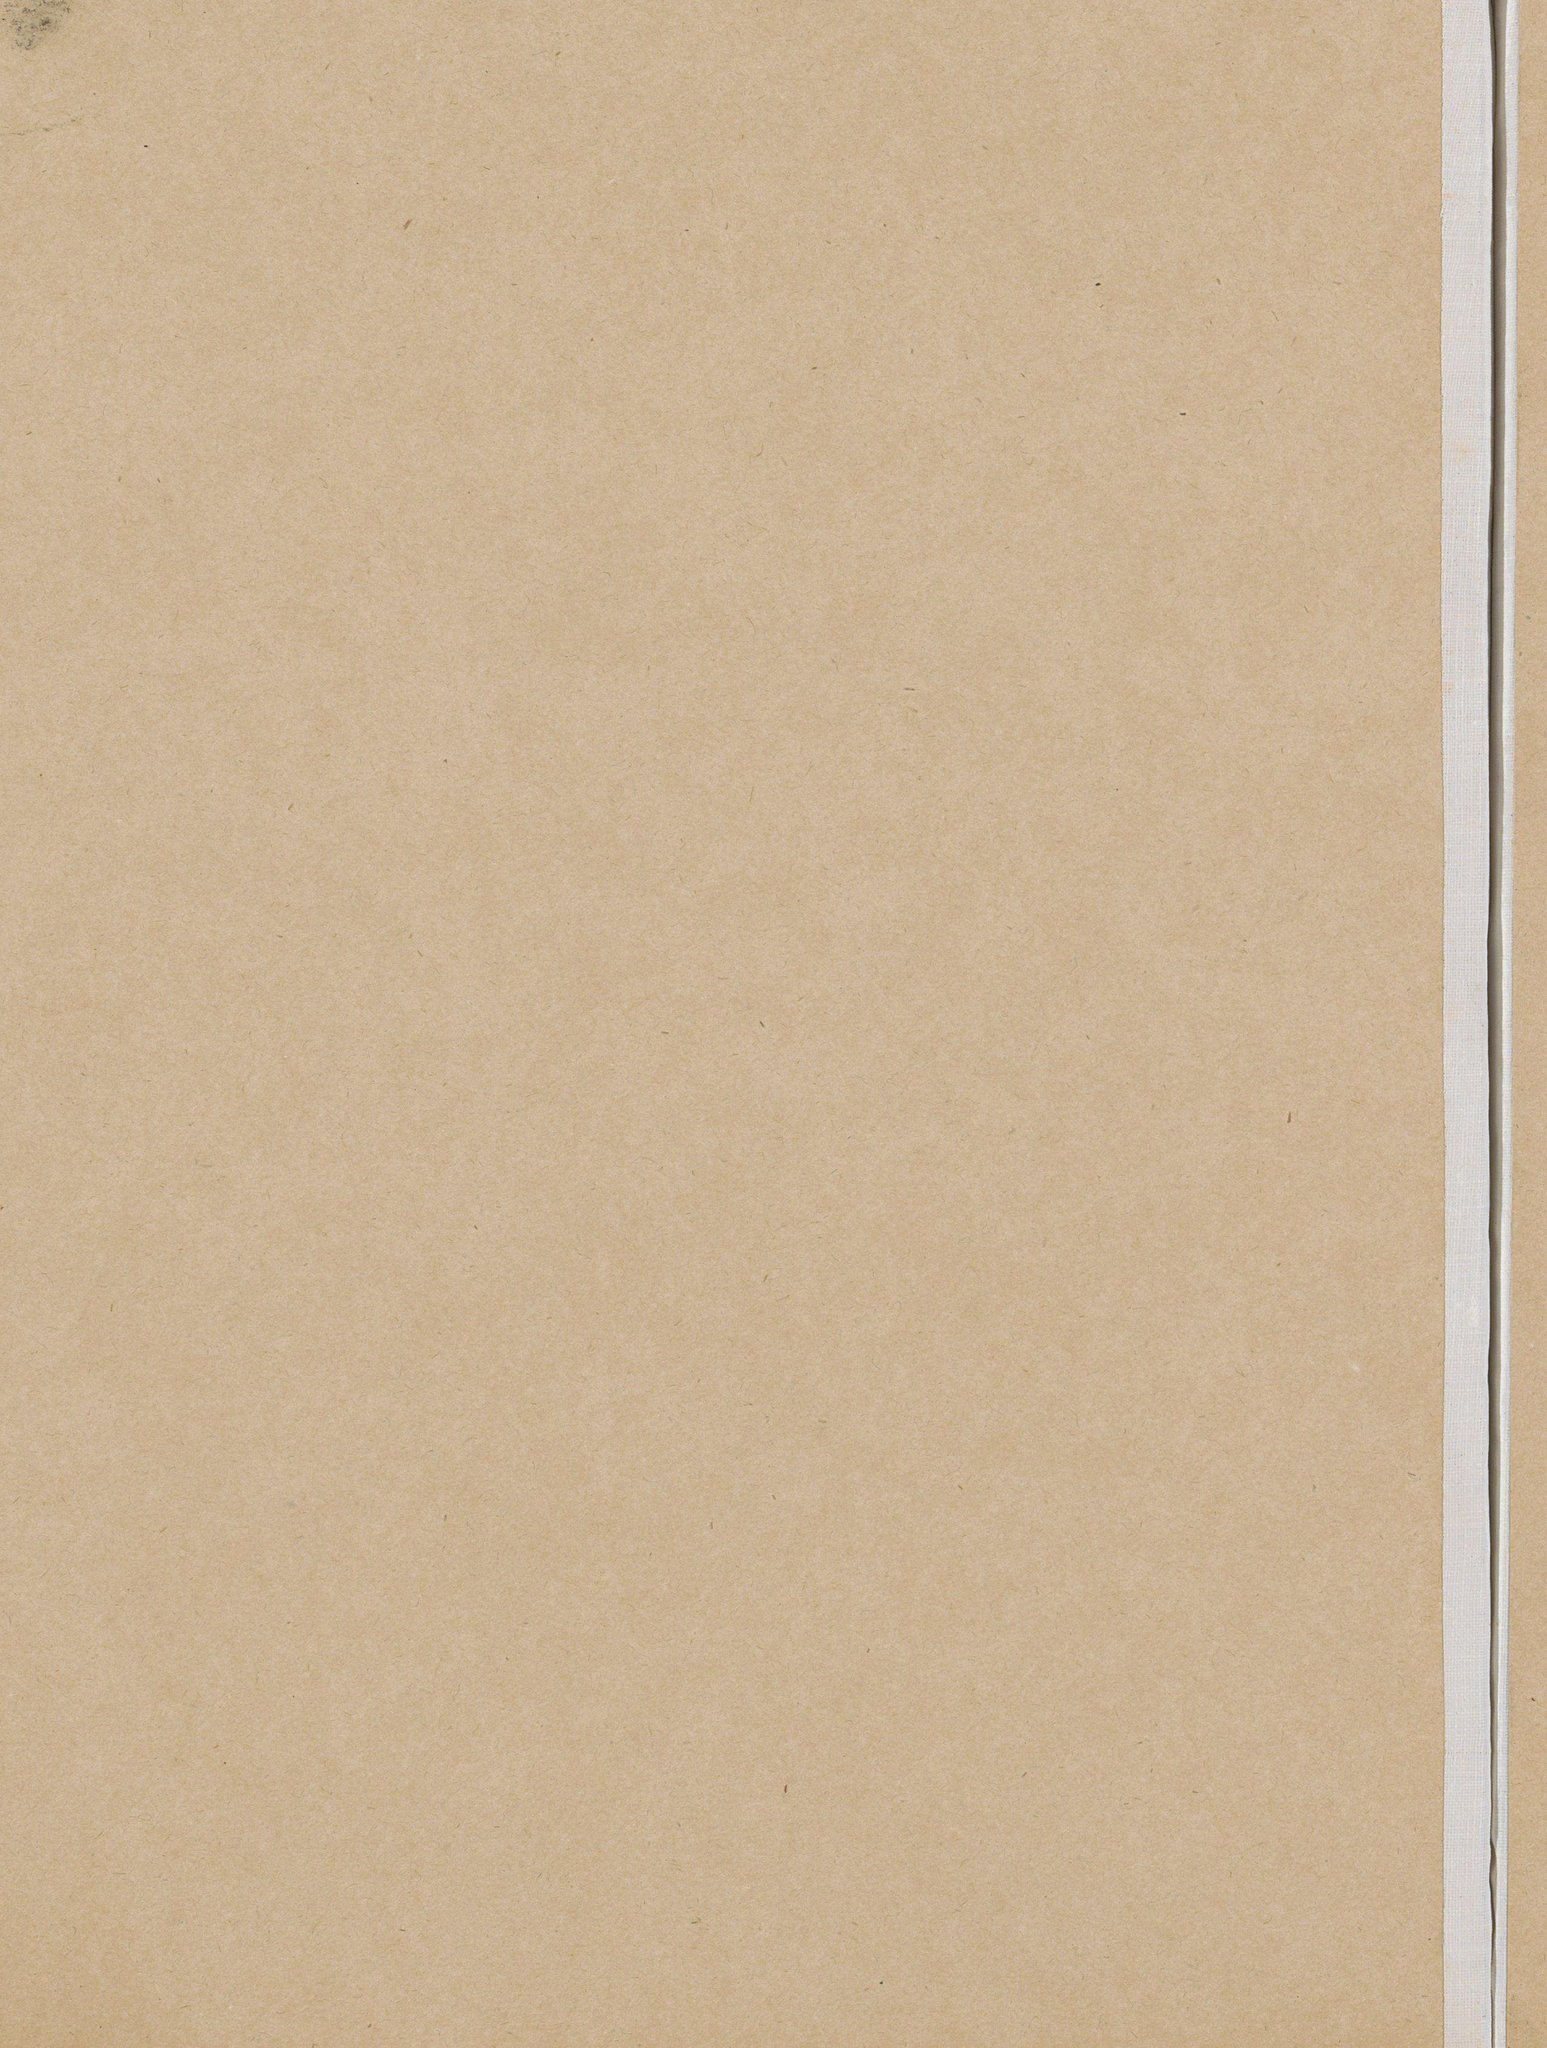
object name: sketchbook leaf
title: Abklatsch van de krijttekening op pagina 23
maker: willem witsen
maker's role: draughtsman, painter, print maker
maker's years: 1860-1923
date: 1874-1923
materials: paper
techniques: printmaking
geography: ewijkshoeve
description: Pagina 22 uit een schetsboek met 72 bladen.